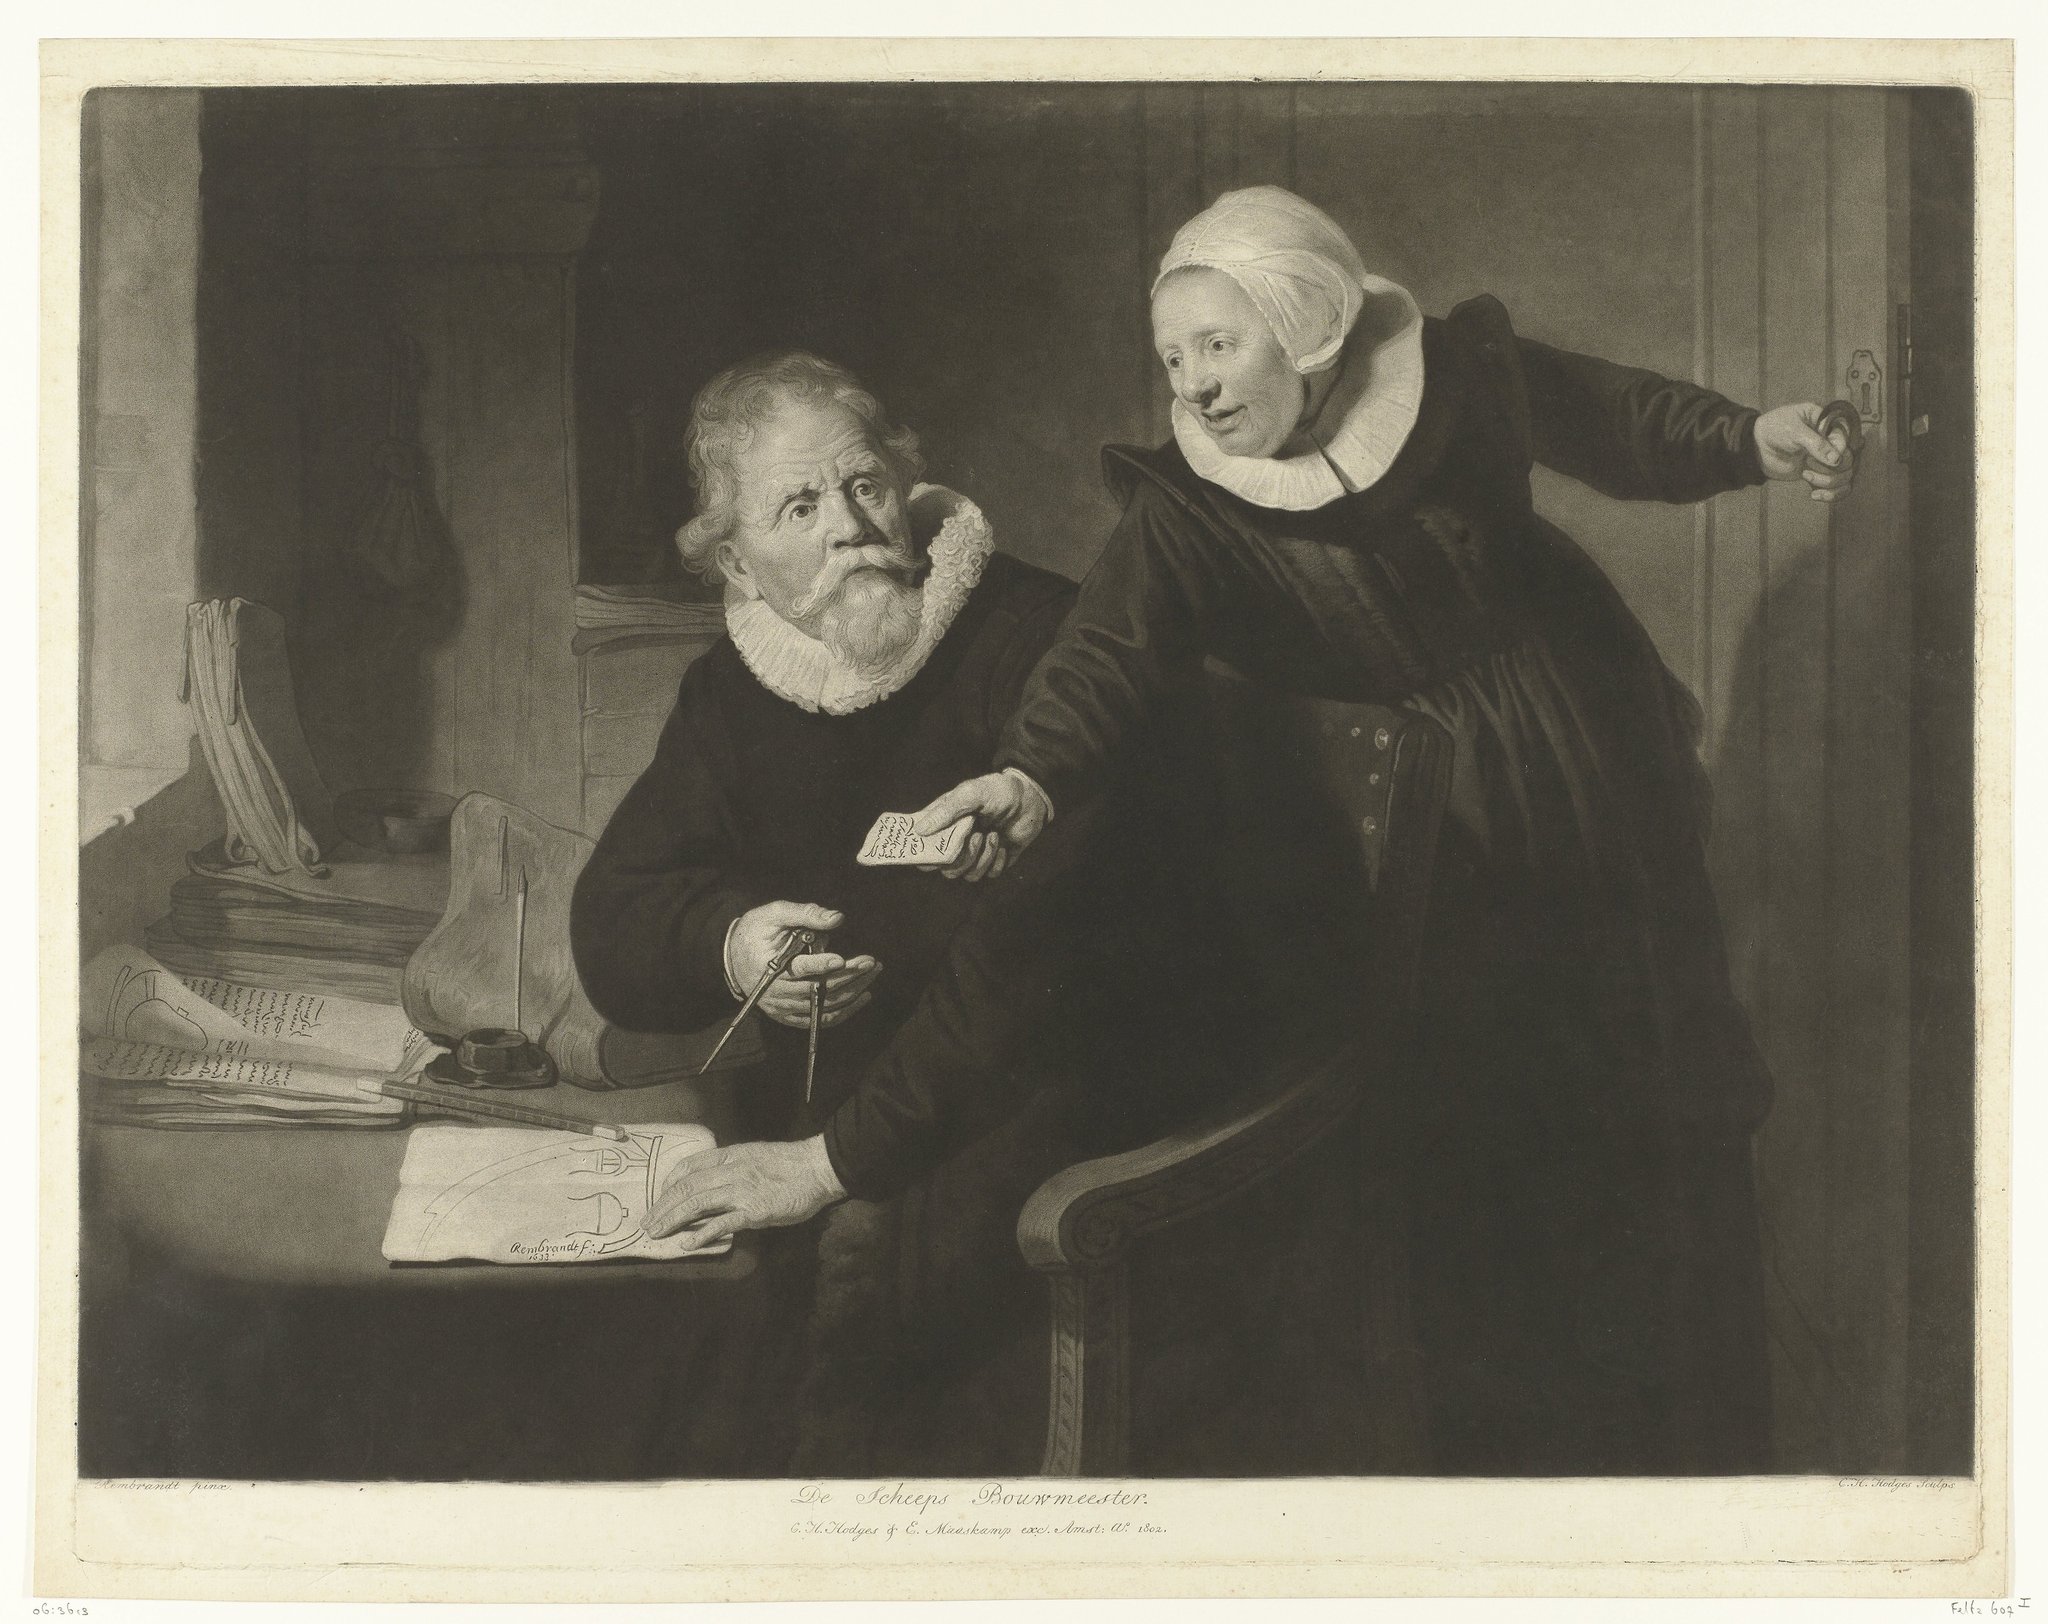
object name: print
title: Scheepsbouwer Jan Rijcksen en zijn vrouw Griet Jans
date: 1802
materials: paper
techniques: etching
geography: amsterdam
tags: marriage, married couple, 'matrimonium', shipbuilding industry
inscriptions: collector's mark: Lugt 2228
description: Griet Jans komt de kamer binnen om haar man Jan Rijcksen een brief te geven. Met de passer nog in de hand neemt hij de brief aan. Op tafel voor hem ligt het ontwerp van een scheepskiel.